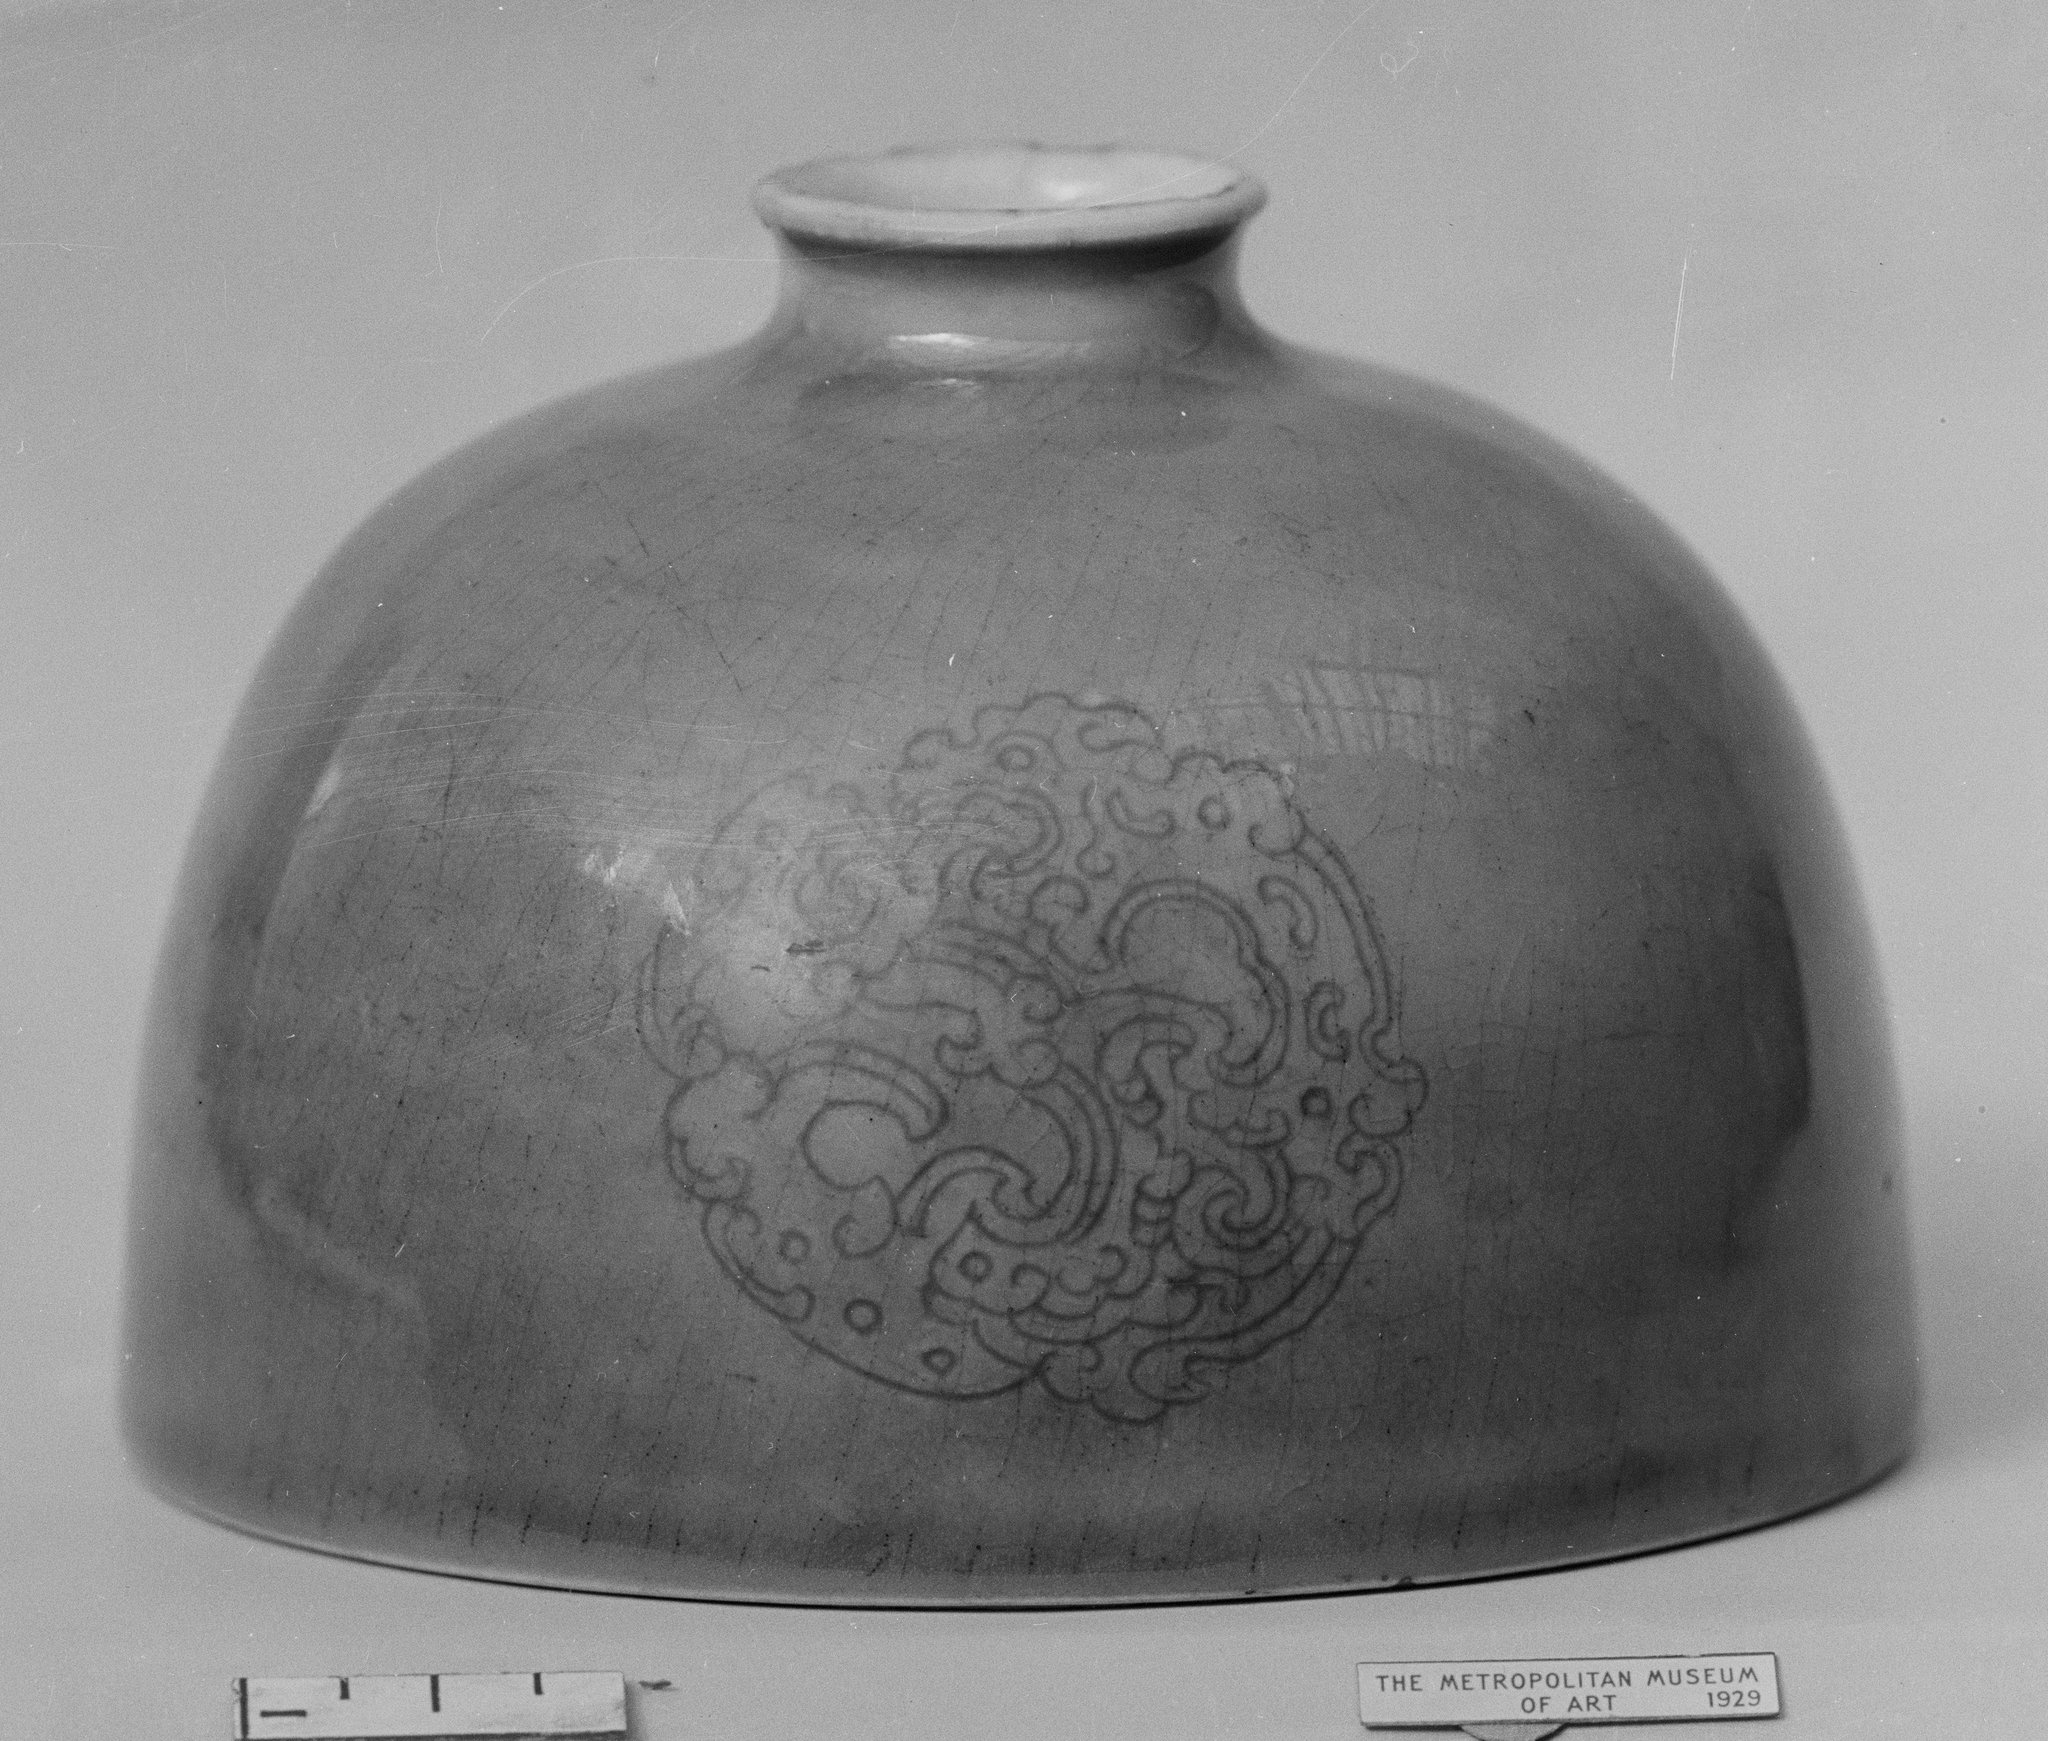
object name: water coupe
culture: chinese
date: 1662-1722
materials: glaze, porcelain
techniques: incising